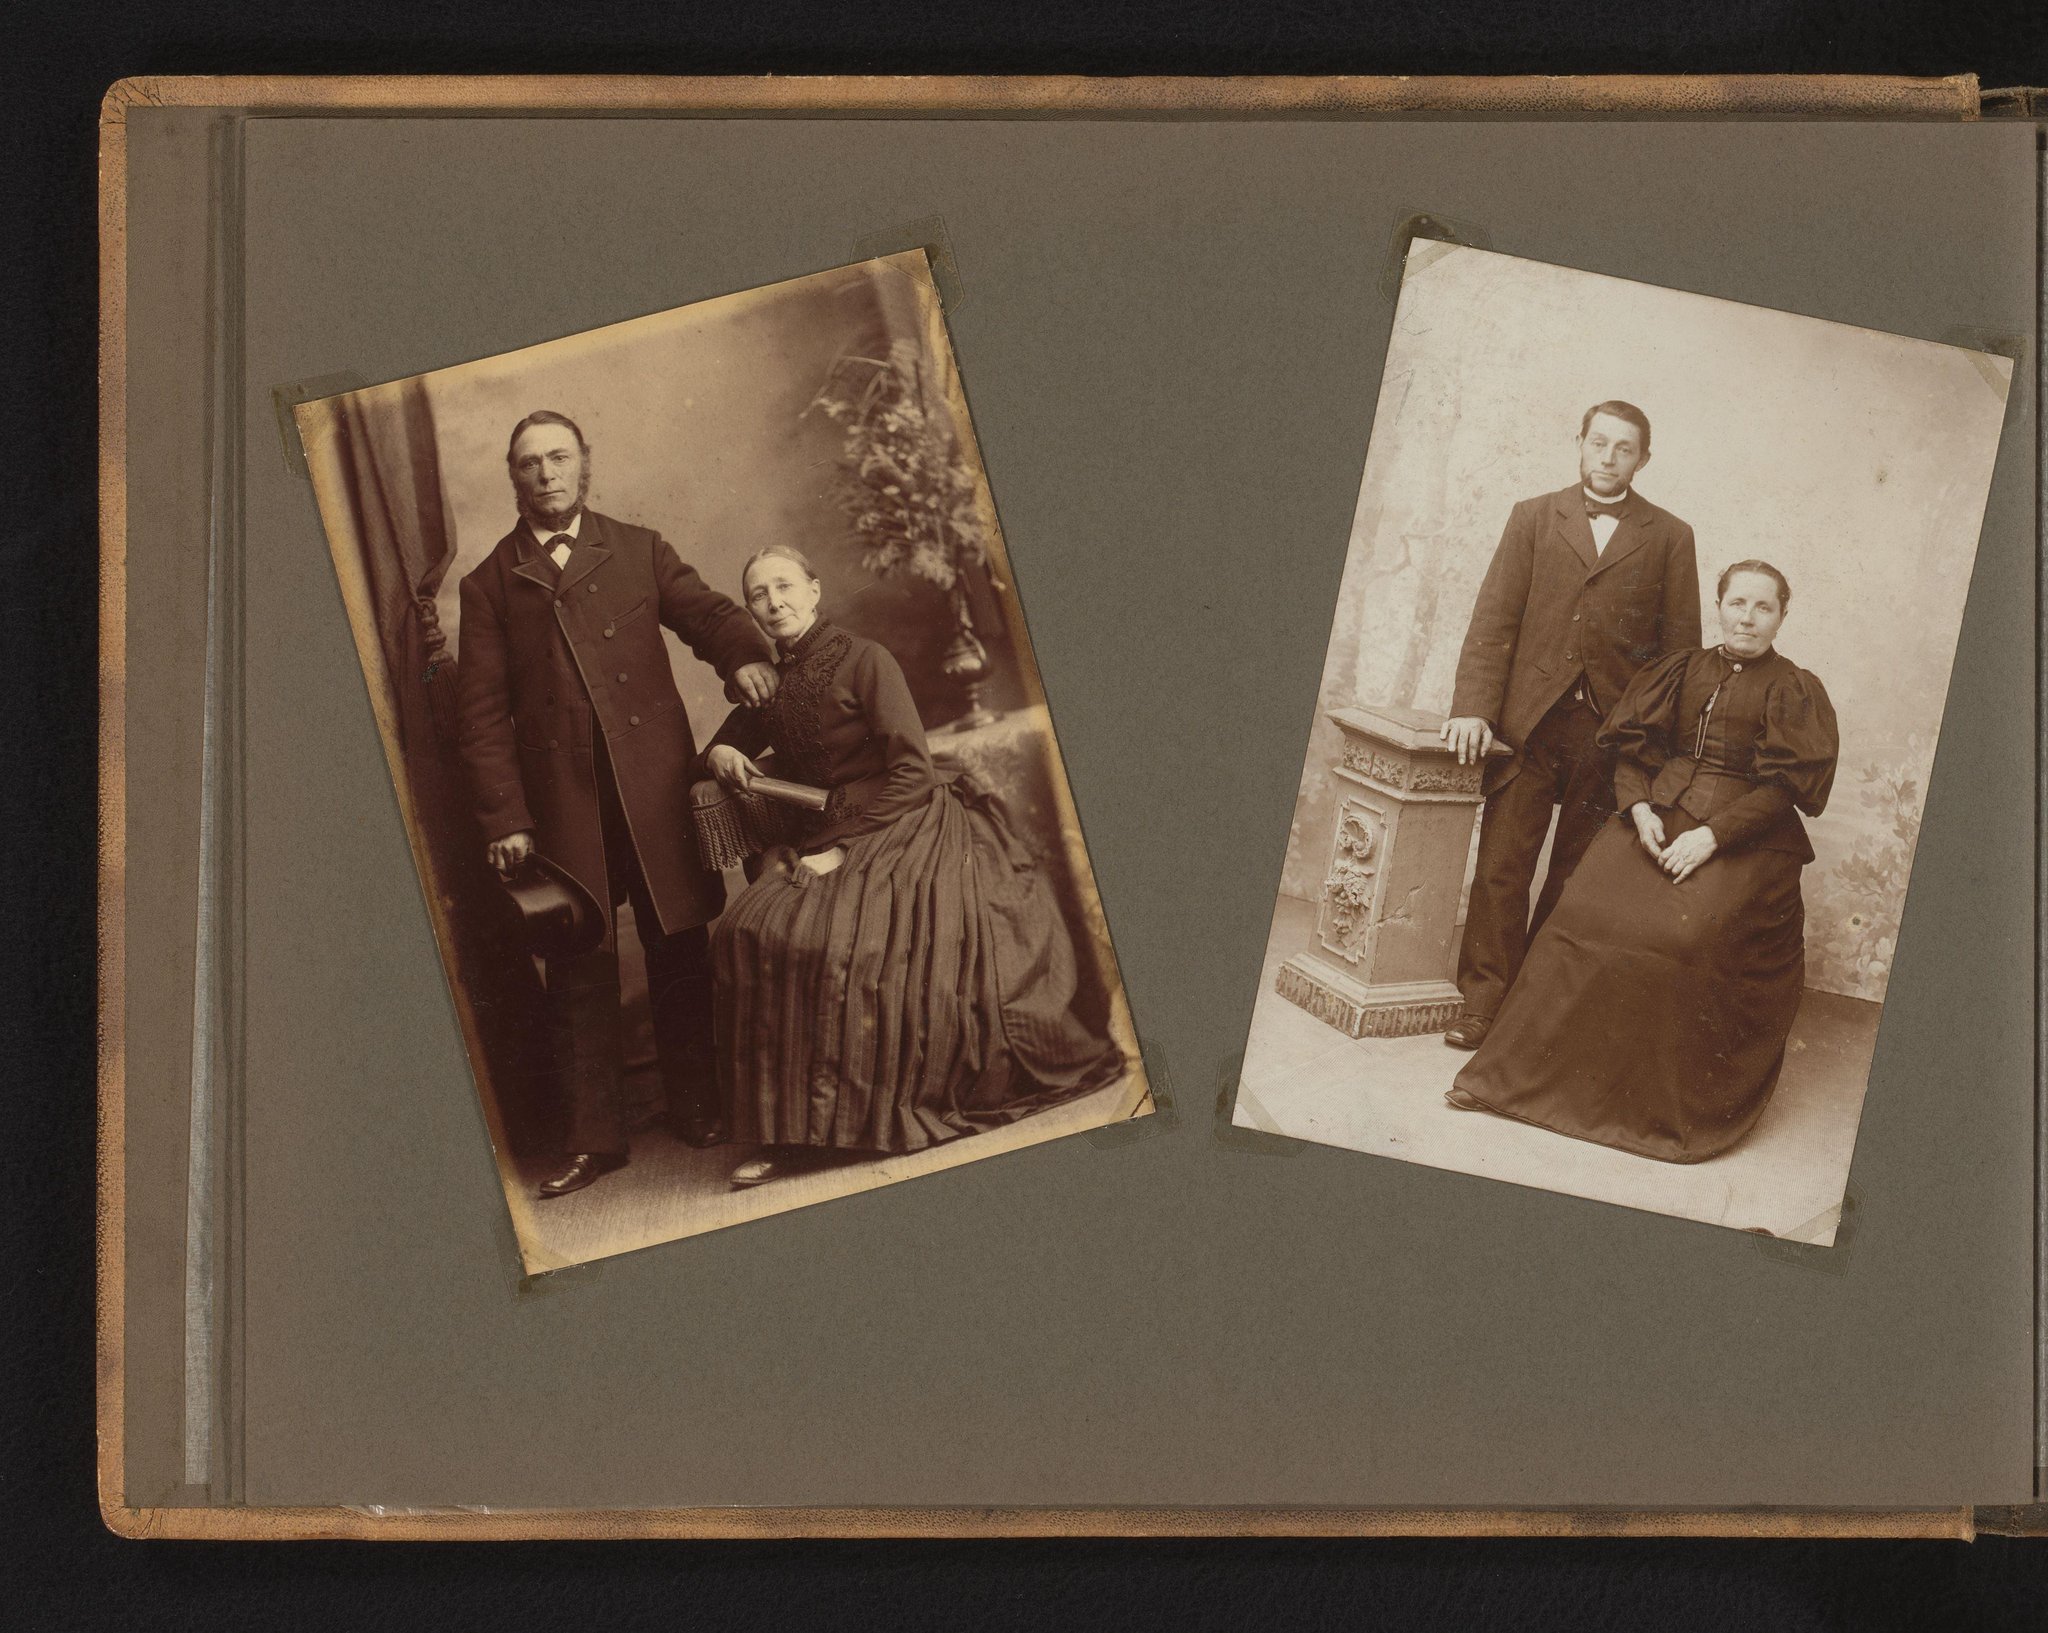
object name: album leaf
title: Twee echtparen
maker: Anonymous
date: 1900-1950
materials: photographic support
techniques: albumen print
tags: adult woman, adult man, historical persons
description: Deze pagina maakt deel uit van een album.